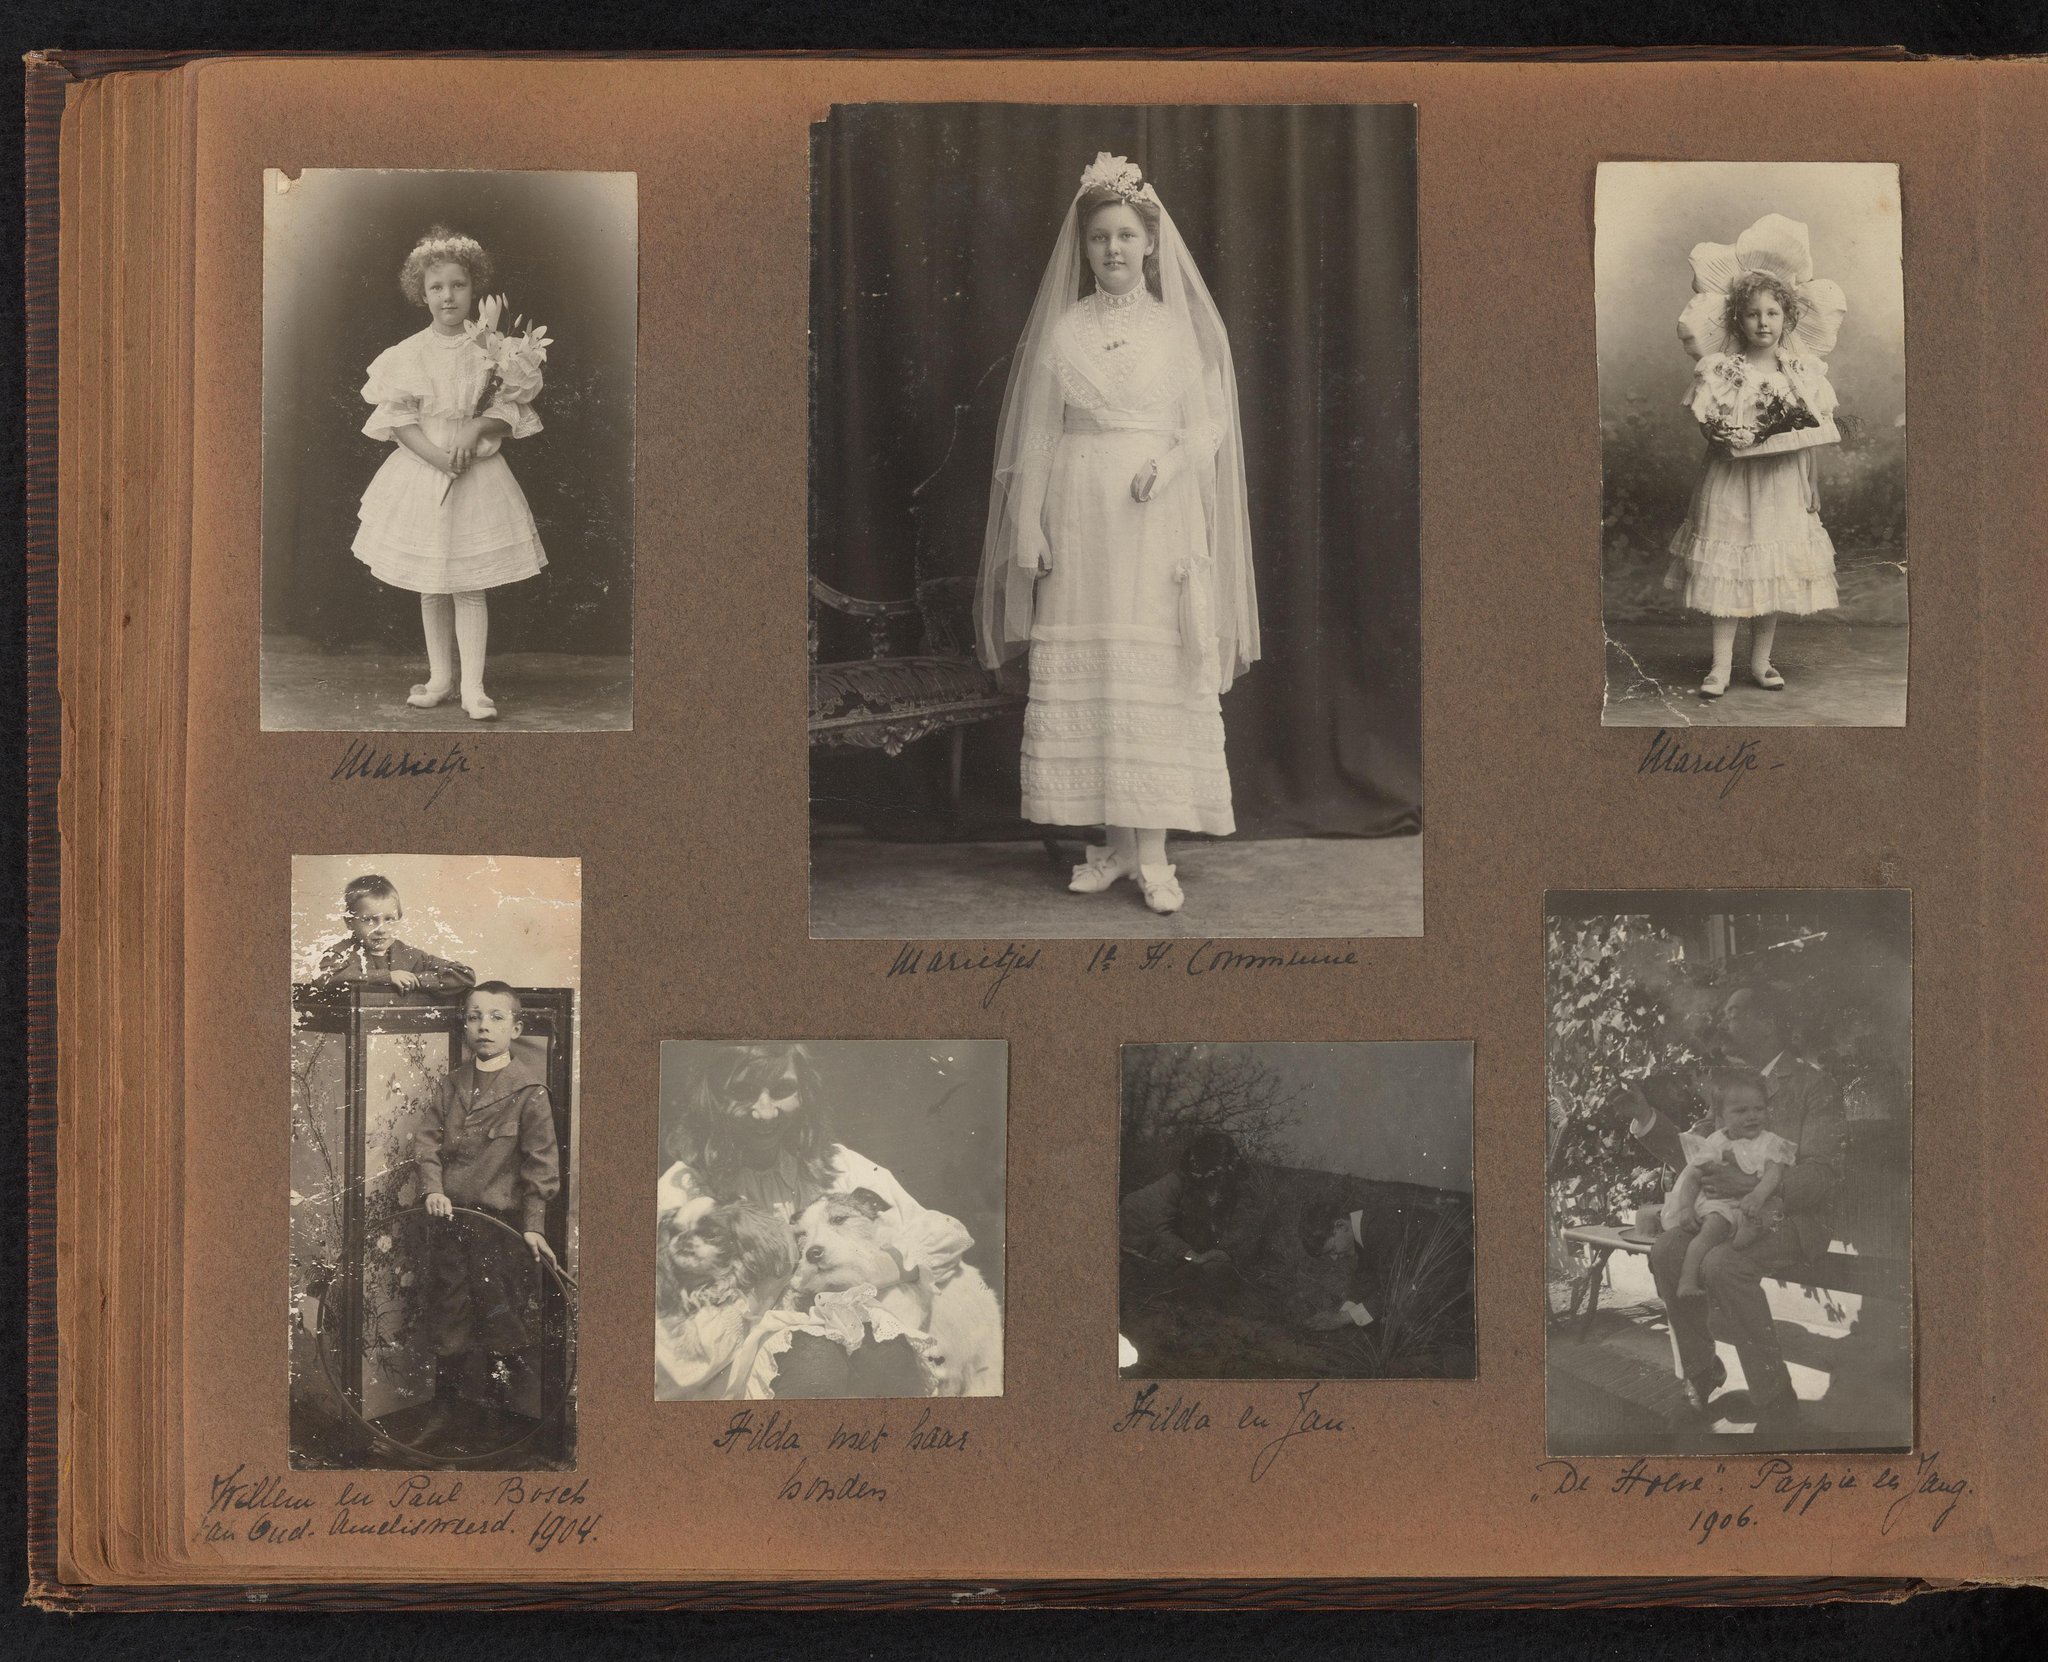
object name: photograph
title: Bladzijde uit het fotoalbum van de familie Diepenbrock met 7 foto's van Alphons Diepenbrock en zijn omgeving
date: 1904-1906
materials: cardboard, photographic support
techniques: photography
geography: amsterdam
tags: alphons diepenbrock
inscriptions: inscription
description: Bruin albumblad 26 van familiealbum van Alphons Diepenbrock.